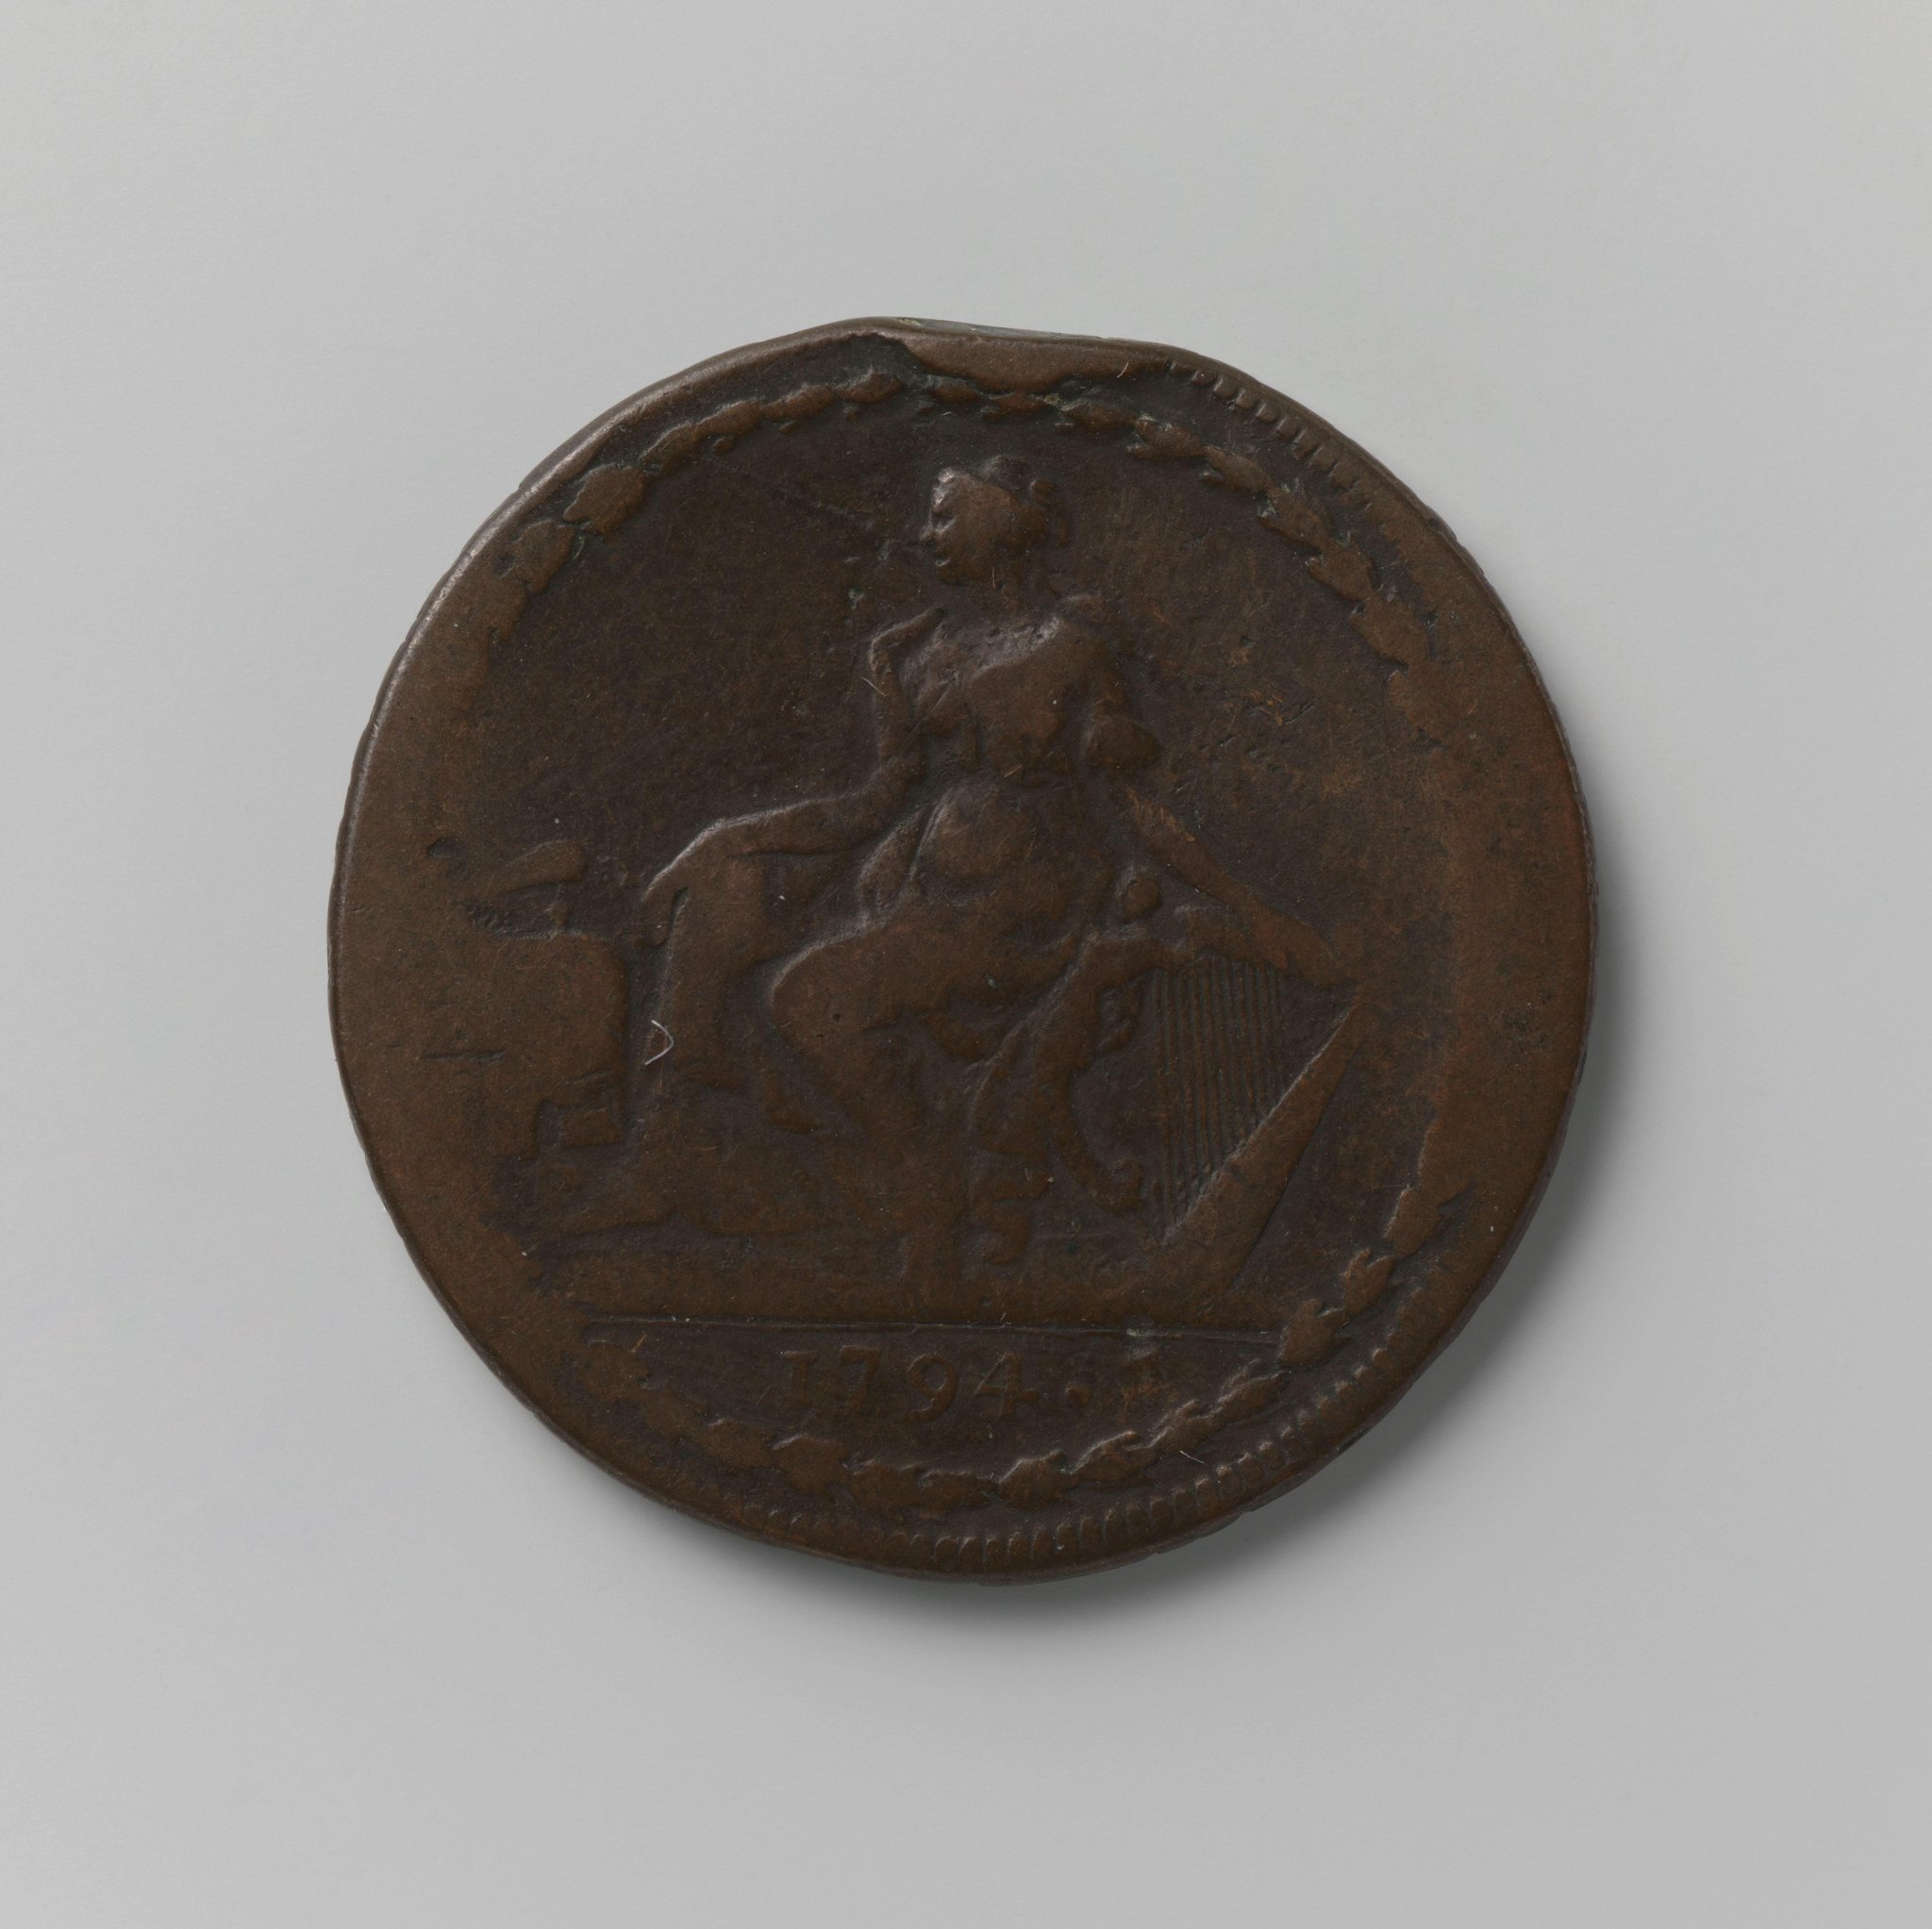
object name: monetary token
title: Ierland, Dublin, ½ penny-token, 1794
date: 1794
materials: copper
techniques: striking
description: Koperen munt. Voorzijde: monogram. Waarde-aanduiding in omschrift. Keerzijde: zittende Ierse maagd, de linkerhand rustend op een harp. Jaartal in afsnede. Randschrift.